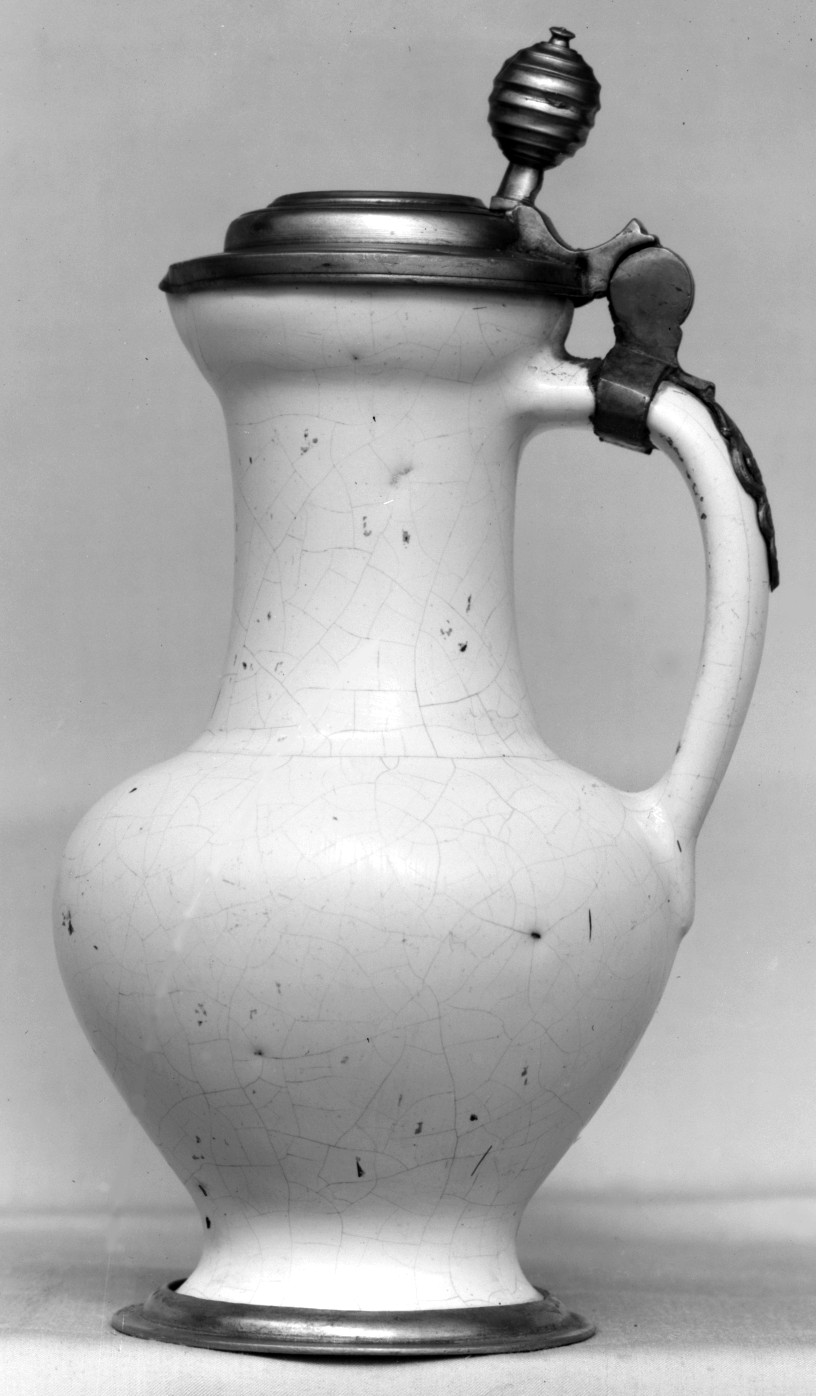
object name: jug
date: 1601-1700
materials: faience, pewter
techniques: glazing